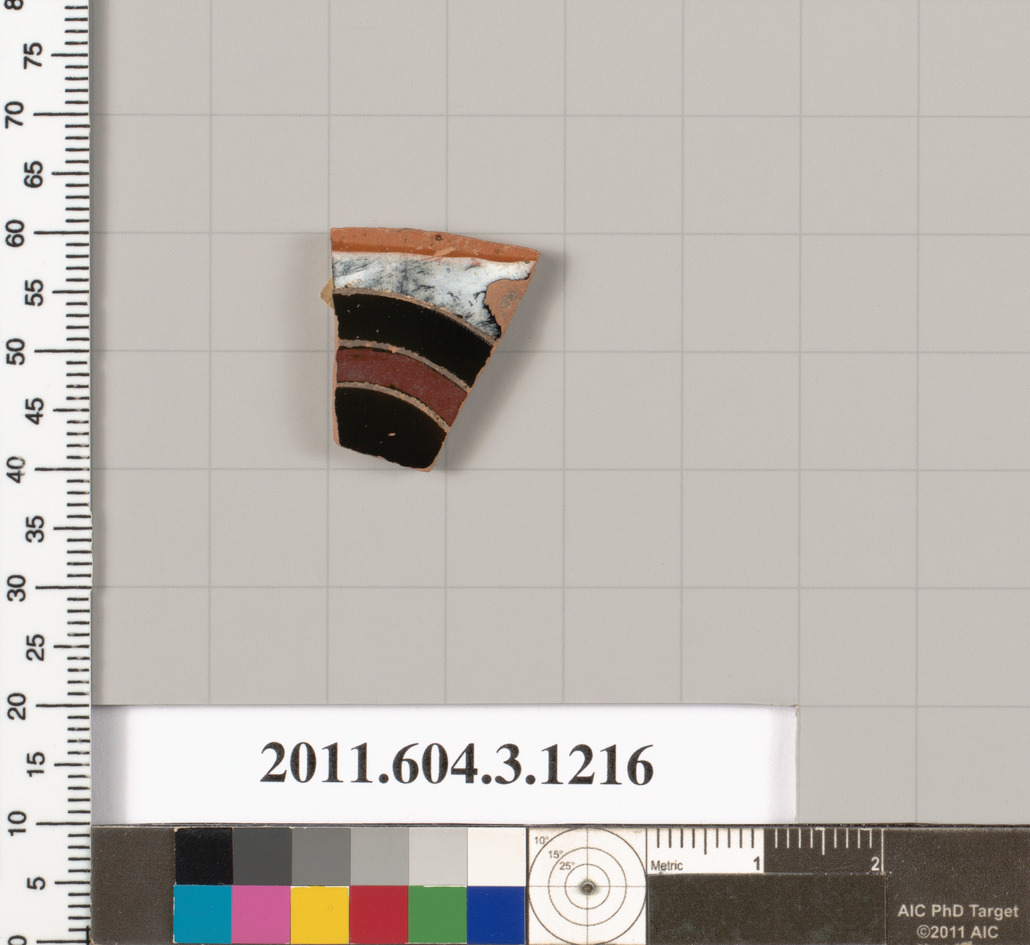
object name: mastoid or kyathos fragment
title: Terracotta fragment of a mastoid (drinking cup with narrow base) or a kyathos (cup-shaped ladle)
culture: greek, attic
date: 534-468 BCE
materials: terracotta